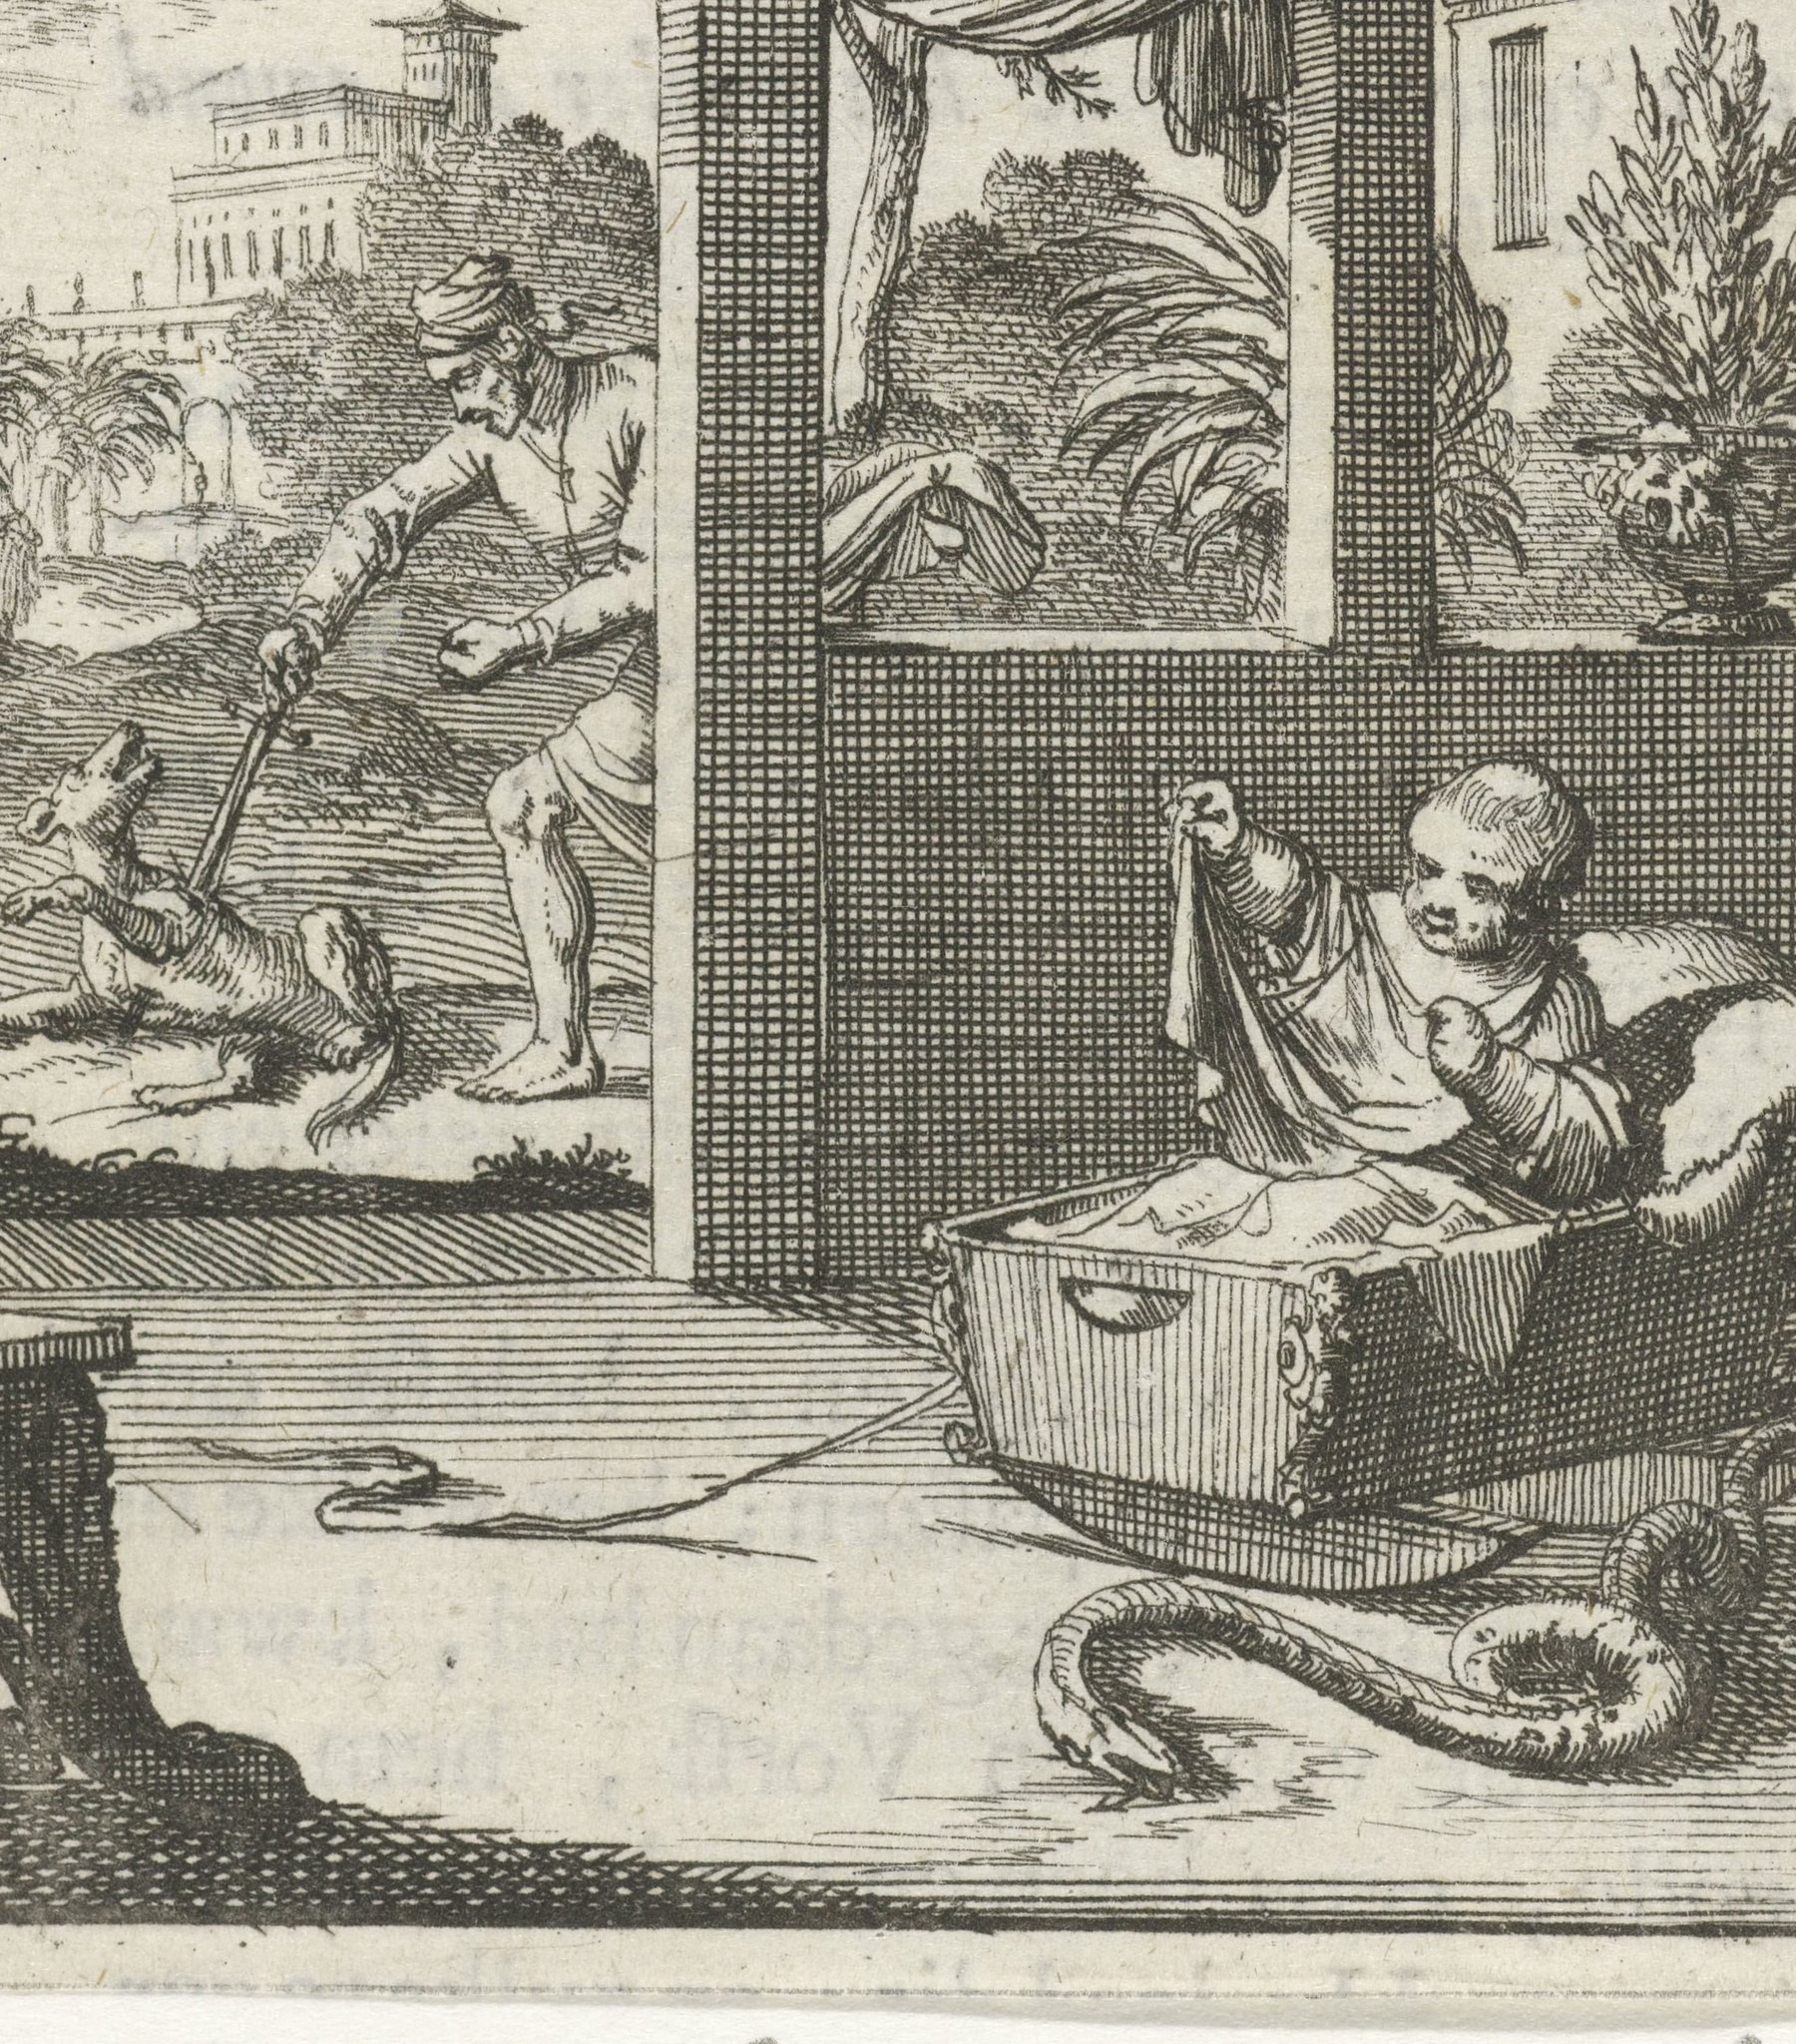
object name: book illustration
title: Kind in een wieg waarnaast een dode slang op de grond ligt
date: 1693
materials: paper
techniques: etching, letterpress printing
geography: amsterdam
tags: snakes, cradle, crib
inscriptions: collector's mark: Lugt 2228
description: Illustratie uit: Duĳkerius, Johannes. Voorbeeldzels der oude wyzen. Waar in (...) de menschelijke hartstogten (...) behandeld worden. Amsterdam: Aart Wolsgrein, 1693, p. 356.